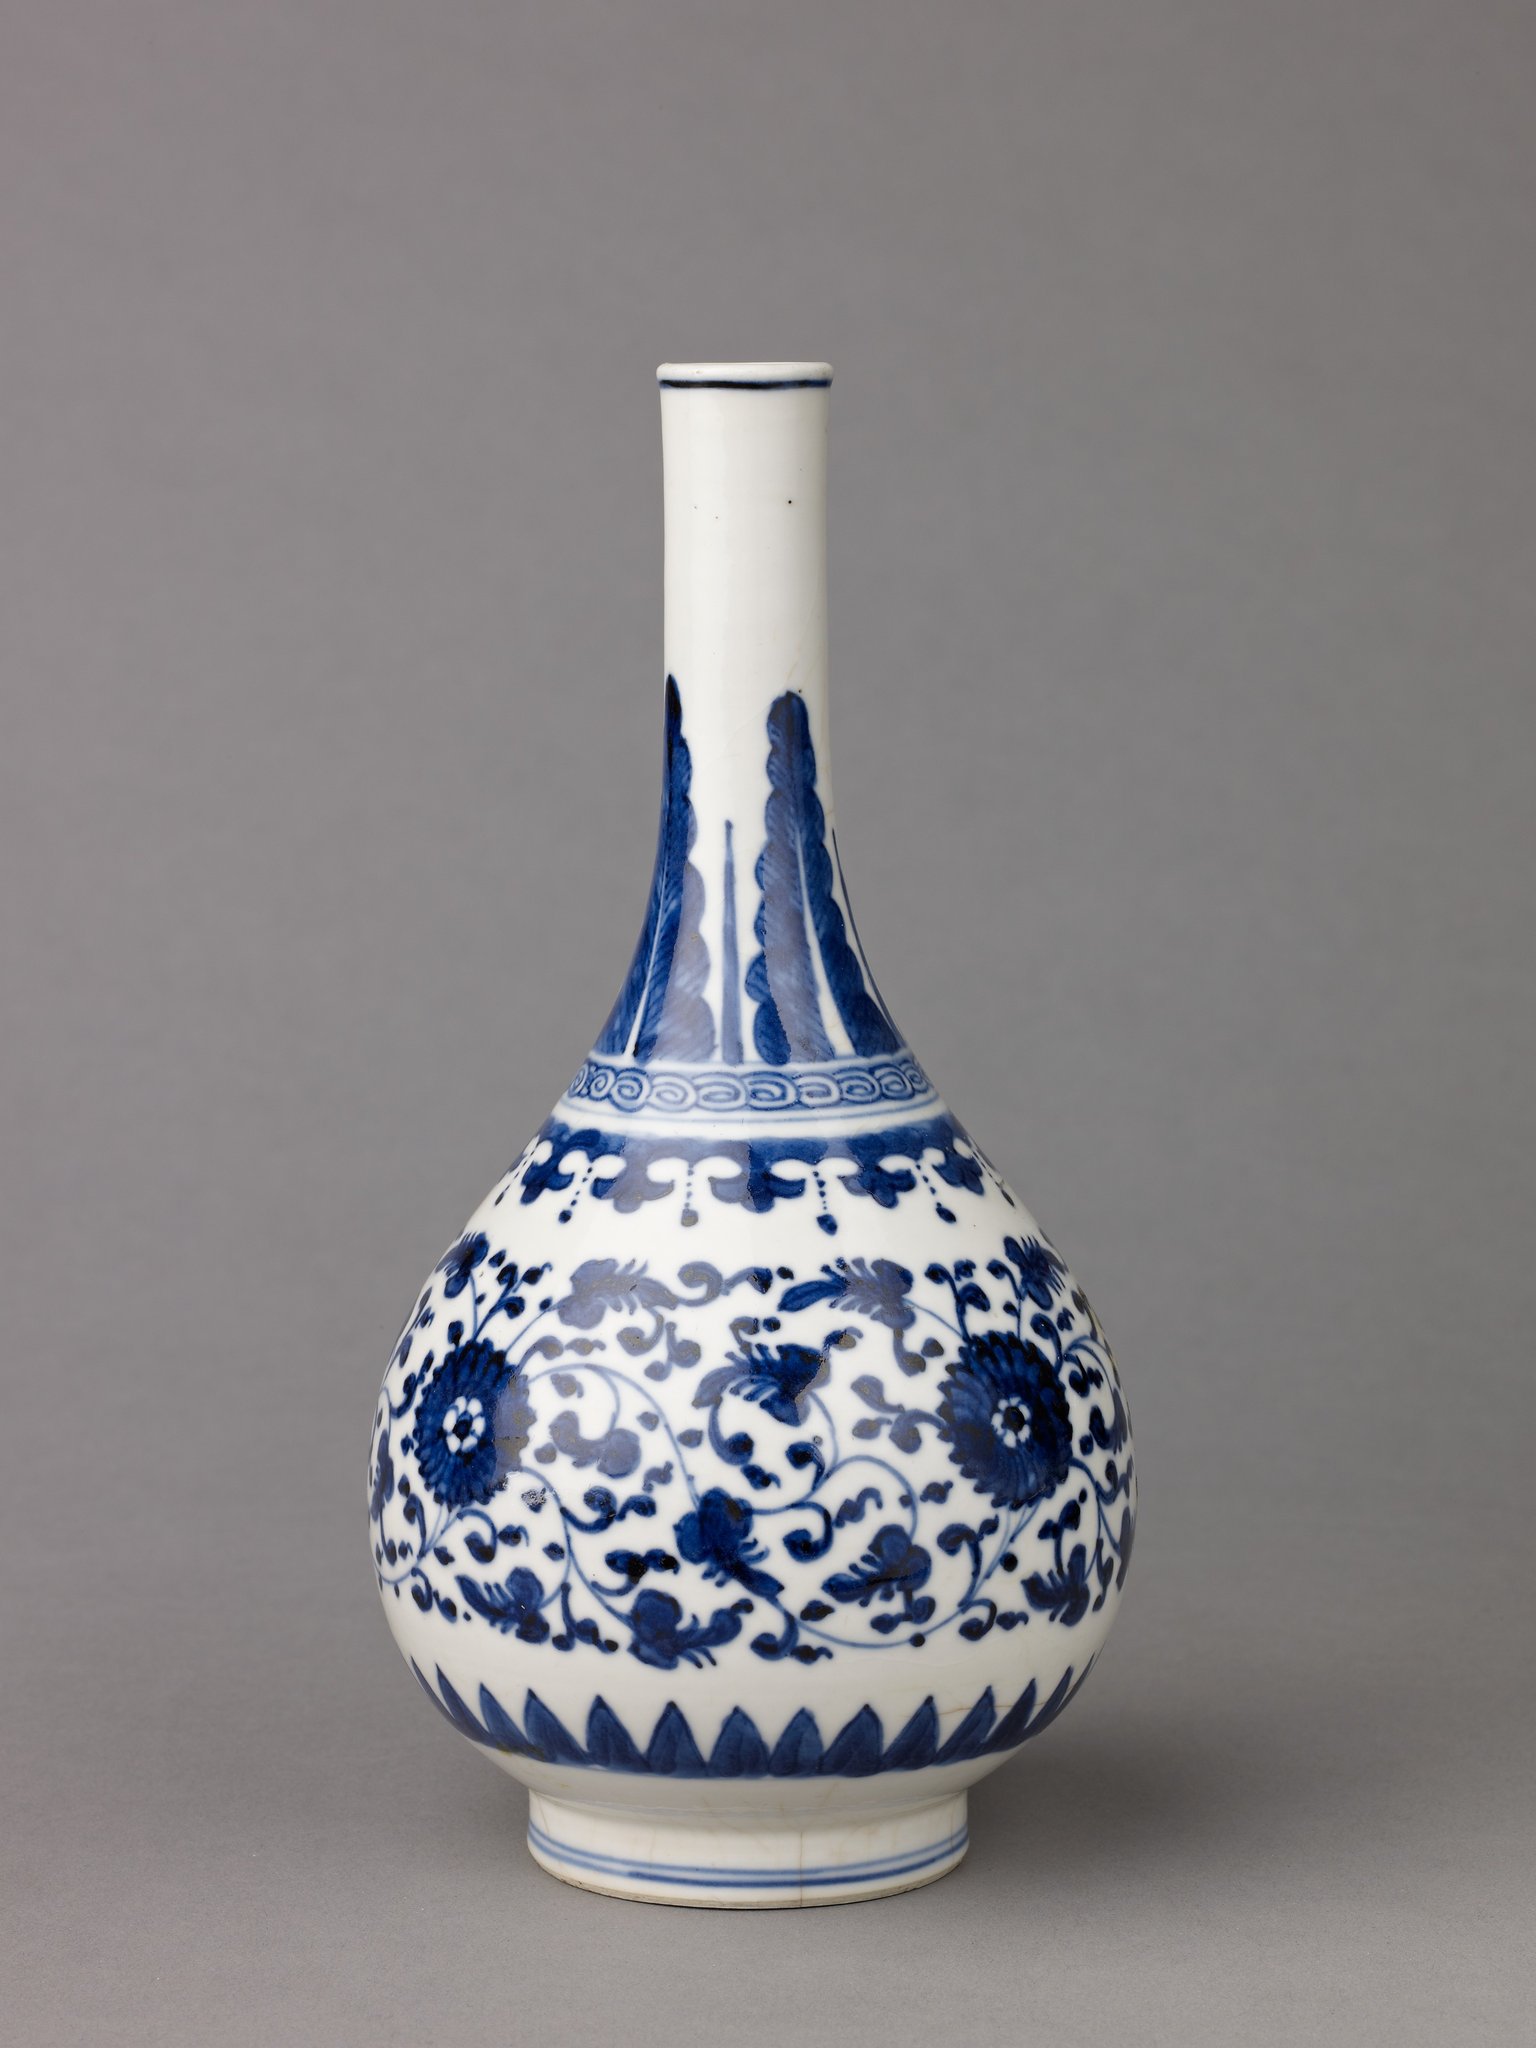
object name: vase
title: Bottle-shaped vase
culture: chinese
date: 1801-1900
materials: porcelain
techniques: painting, underglaze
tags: flowers